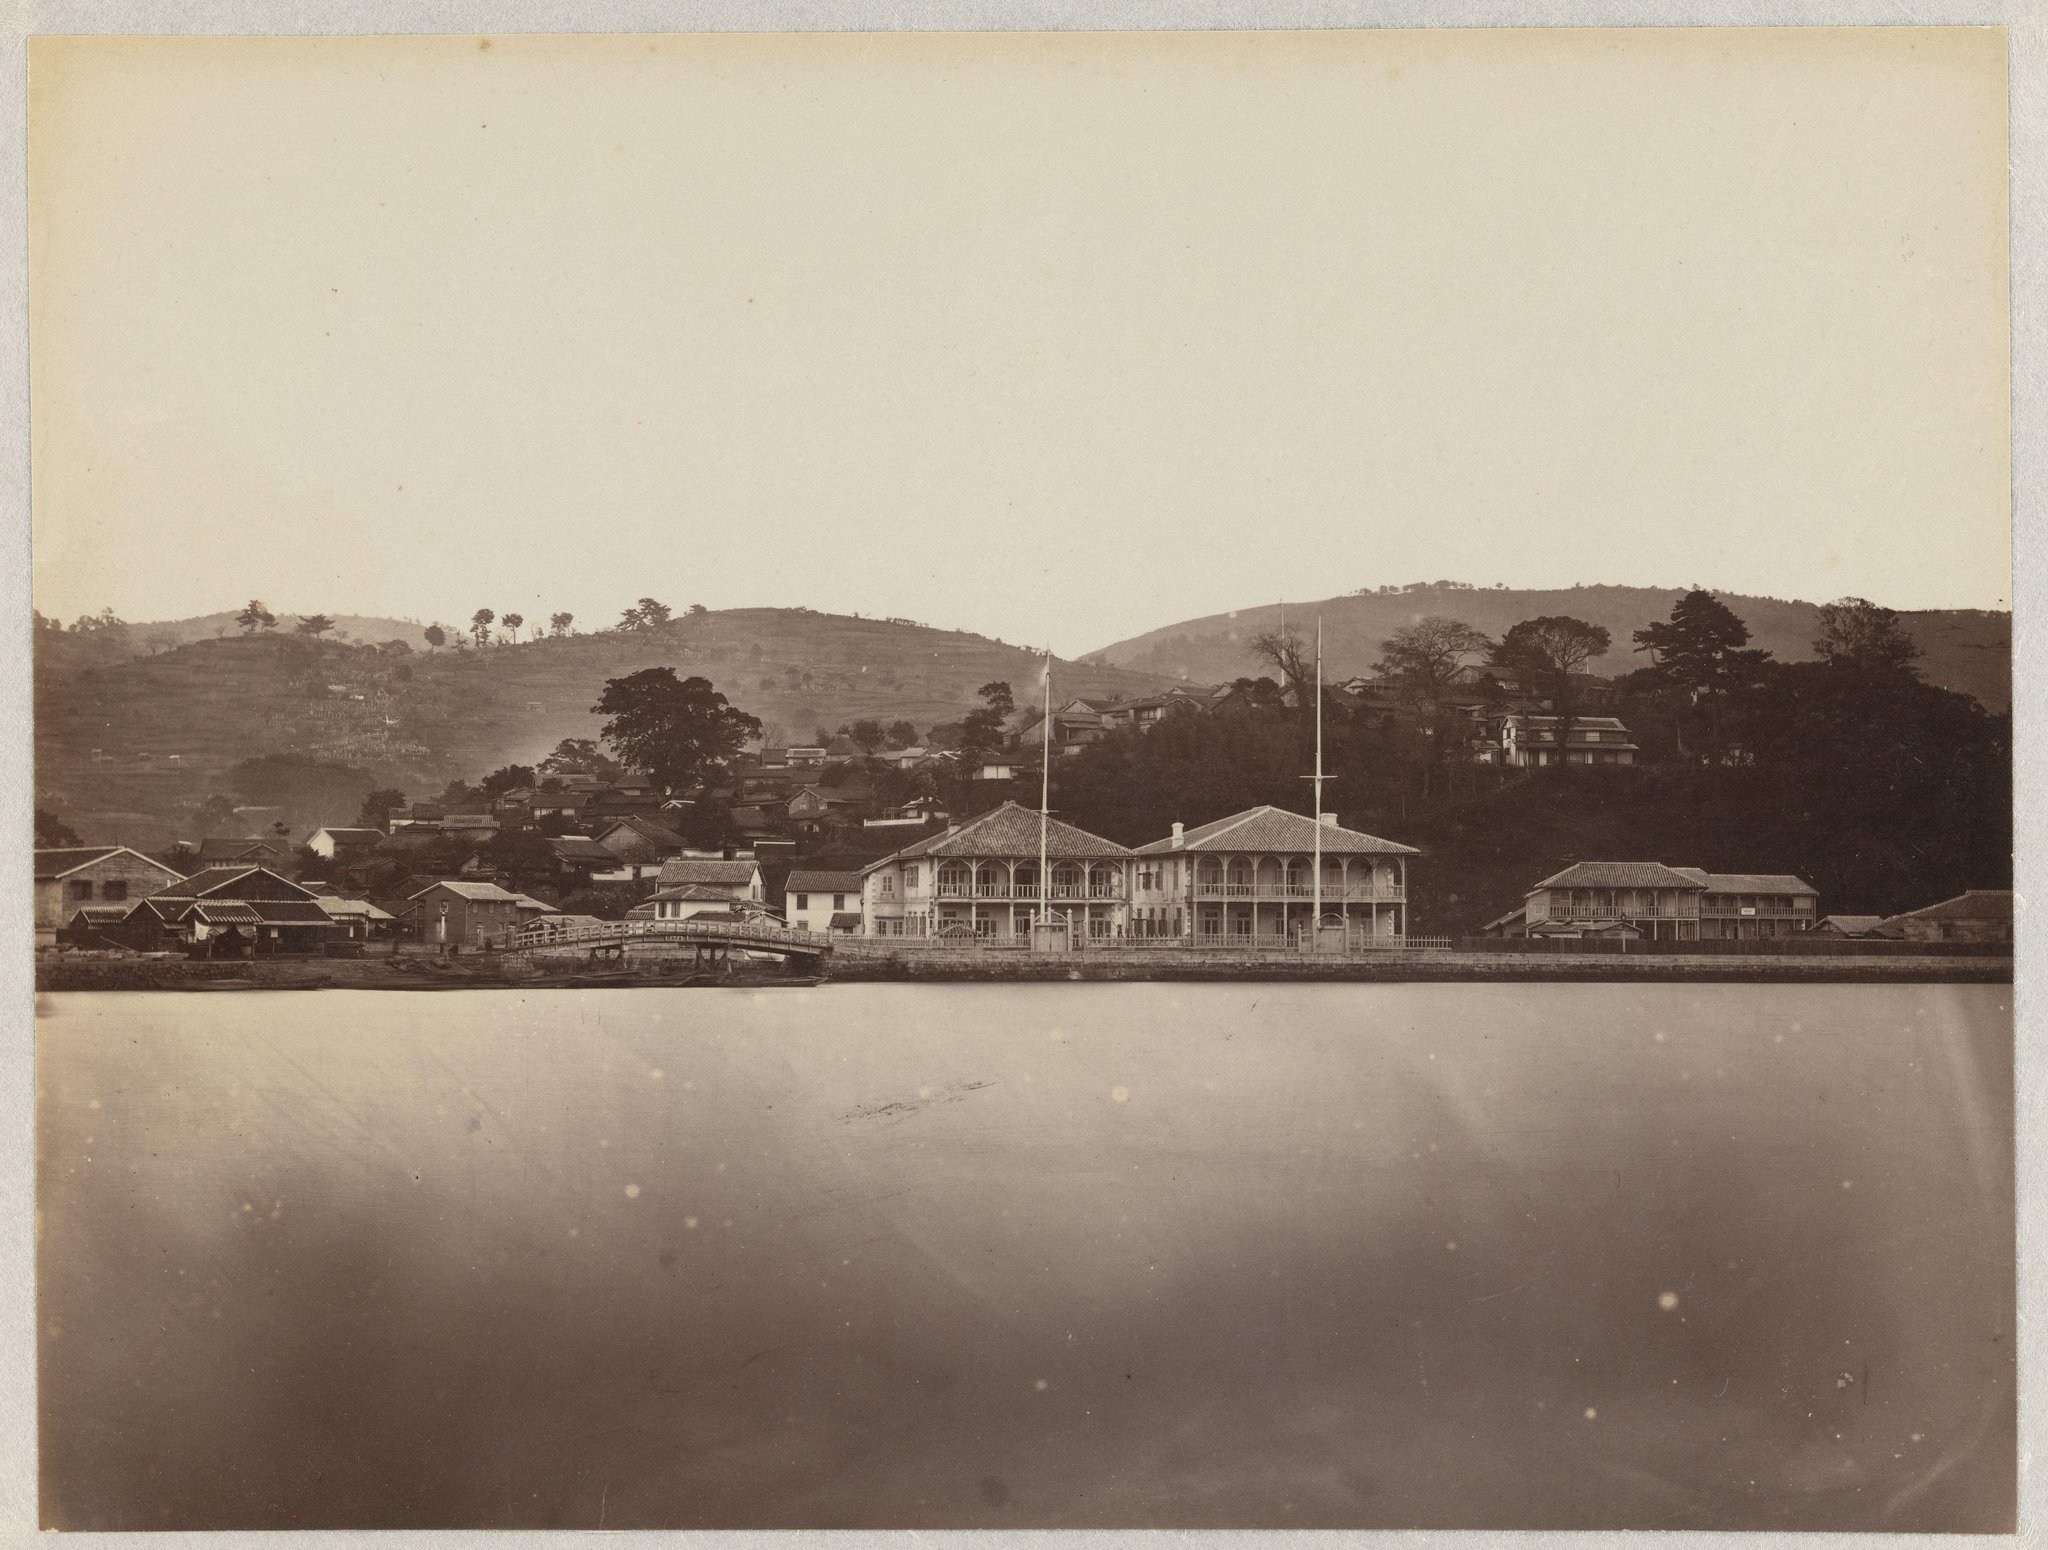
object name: photograph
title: Oura, Nagasaki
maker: Anonymous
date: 1865-1870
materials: paper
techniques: albumen print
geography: japan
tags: japan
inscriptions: number: ‘N5’, number: ‘BD. 122’